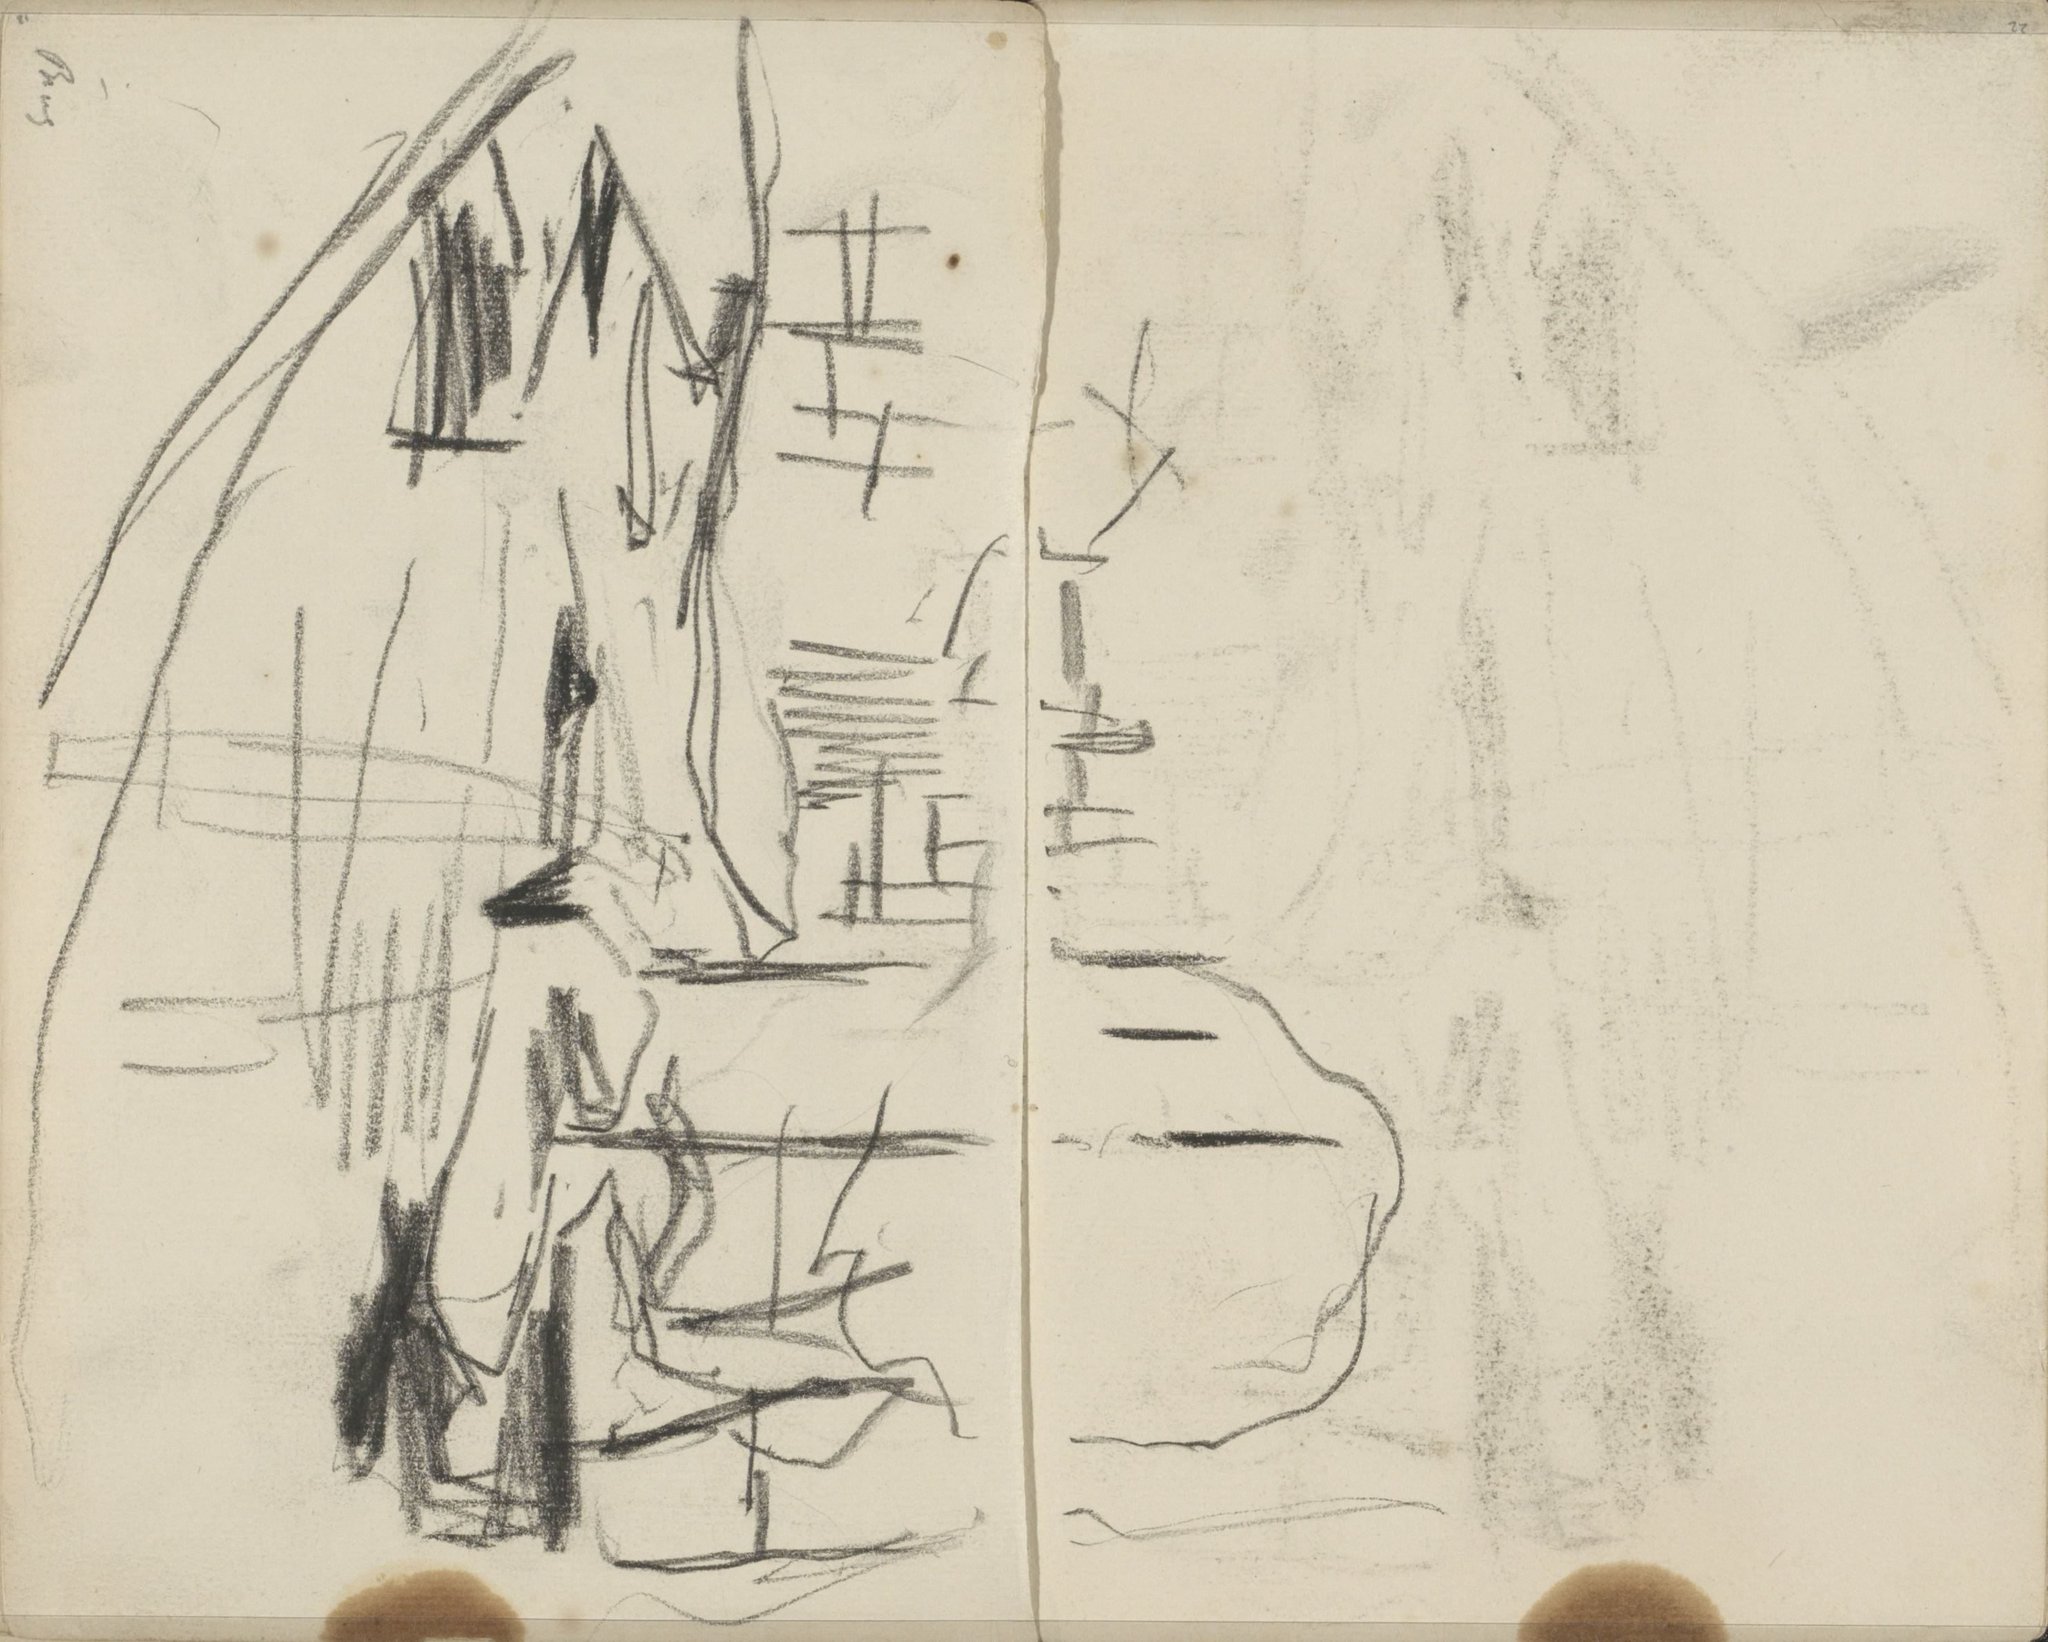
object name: sketchbook leaf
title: Gezicht op een brug in Amsterdam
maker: george hendrik breitner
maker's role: draughtsman, painter, print maker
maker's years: 1857-1923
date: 1887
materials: chalk, paper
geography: amsterdam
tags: bridge in city across river, canal, etc., amsterdam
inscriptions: annotation: ‘Brug’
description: Pagina 21 en pagina 22 uit een schetsboek met 12 bladen.